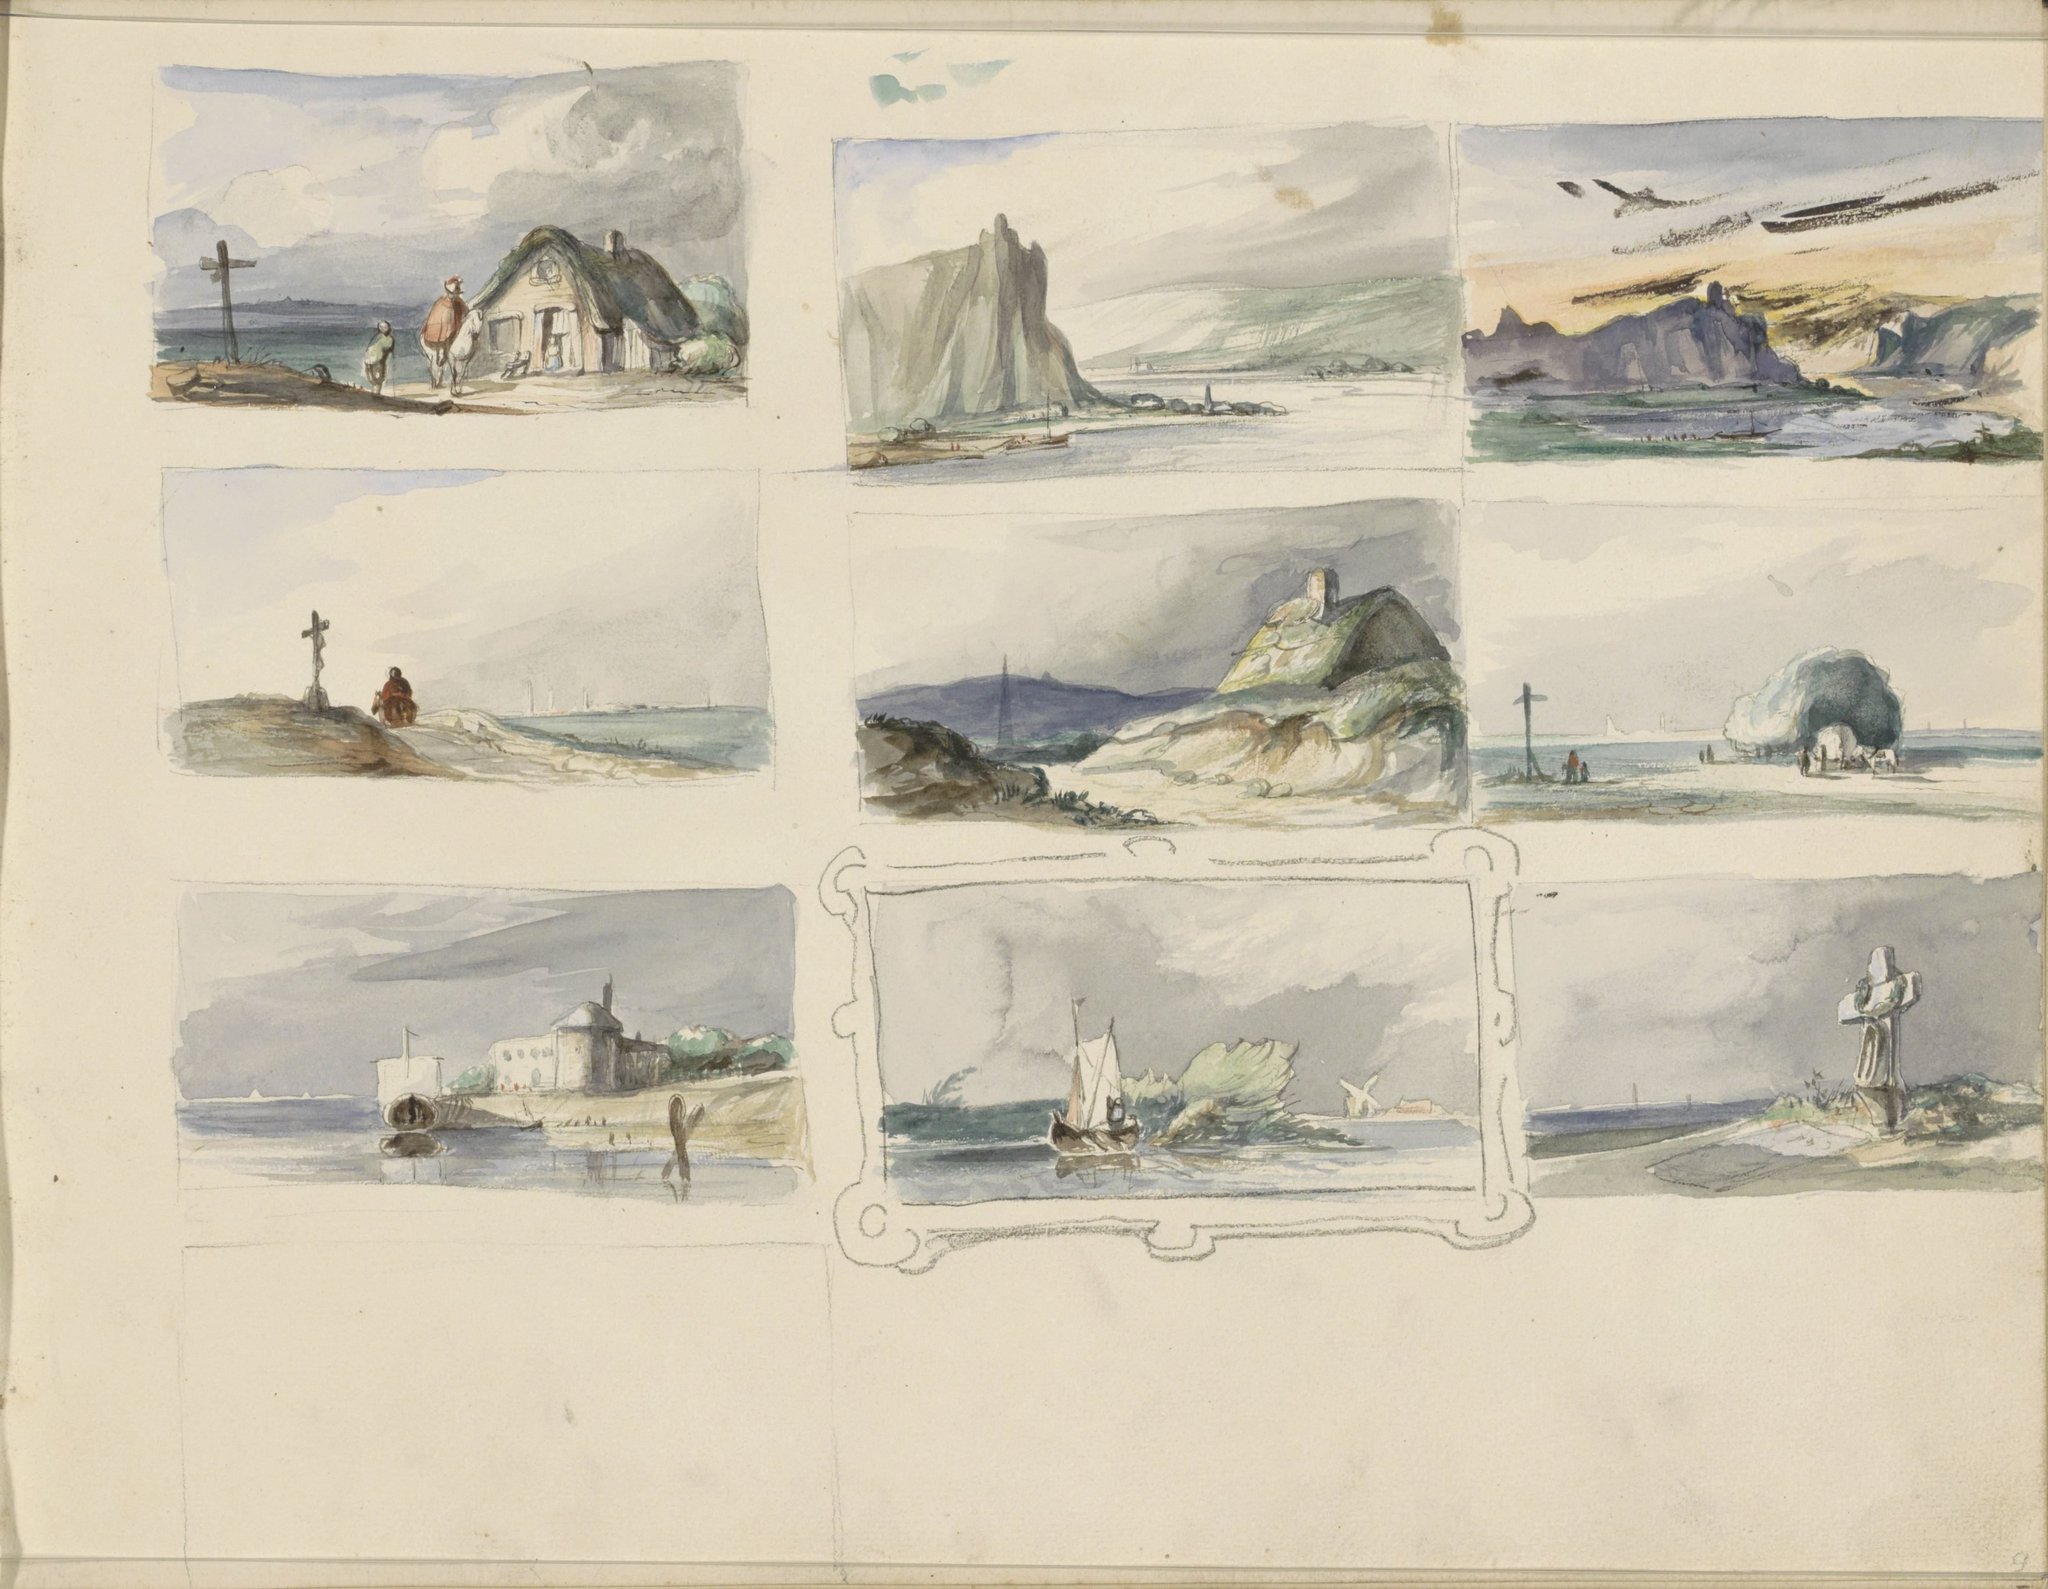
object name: sketchbook leaf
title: Negen berg- en rivierlandschappen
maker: johannes tavenraat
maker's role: draughtsman, painter, print maker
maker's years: 1809-1881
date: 1840-1845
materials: paper, pencil, watercolor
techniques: brush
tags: cross as symbol of christ, landscapes with waters, waterscapes, seascapes (in the temperate zone), landscapes (+ landscape with figures, staffage), mountains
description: Blad 9 recto uit een schetsboek met 43 bladen.